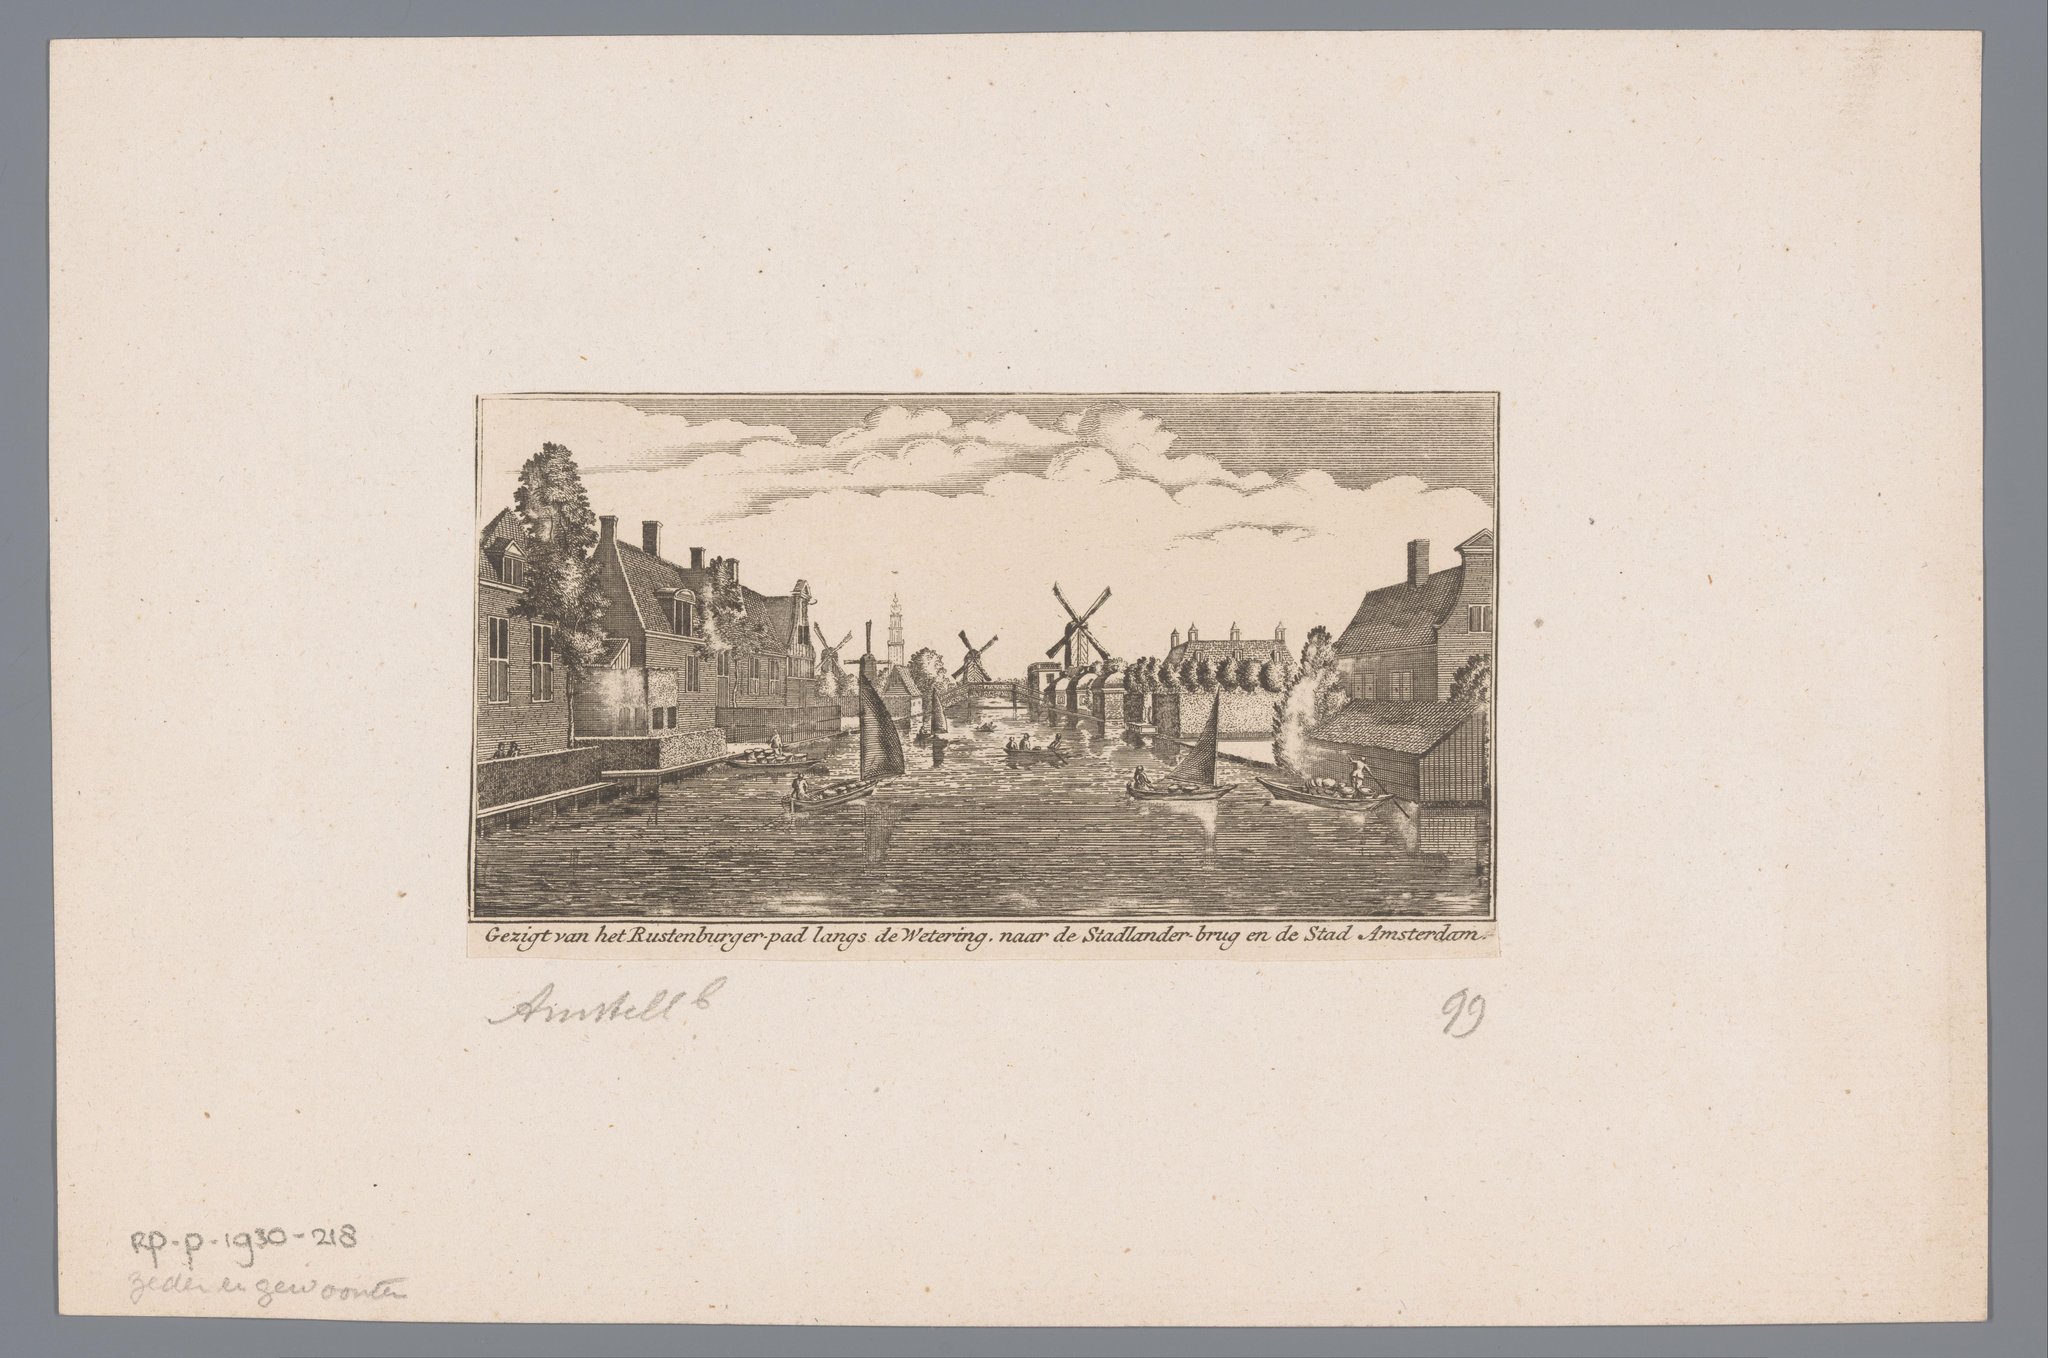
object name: print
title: Gezicht op een wetering richting de Stadlanderbrug en Amsterdam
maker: gerardus condet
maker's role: print maker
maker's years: 1715-1764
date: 1725-1764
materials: paper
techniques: etching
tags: rowing-boat, canoe, etc., house combined with shop, bridge in city across river, canal, etc., windmill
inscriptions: collector's mark: Lugt 2233